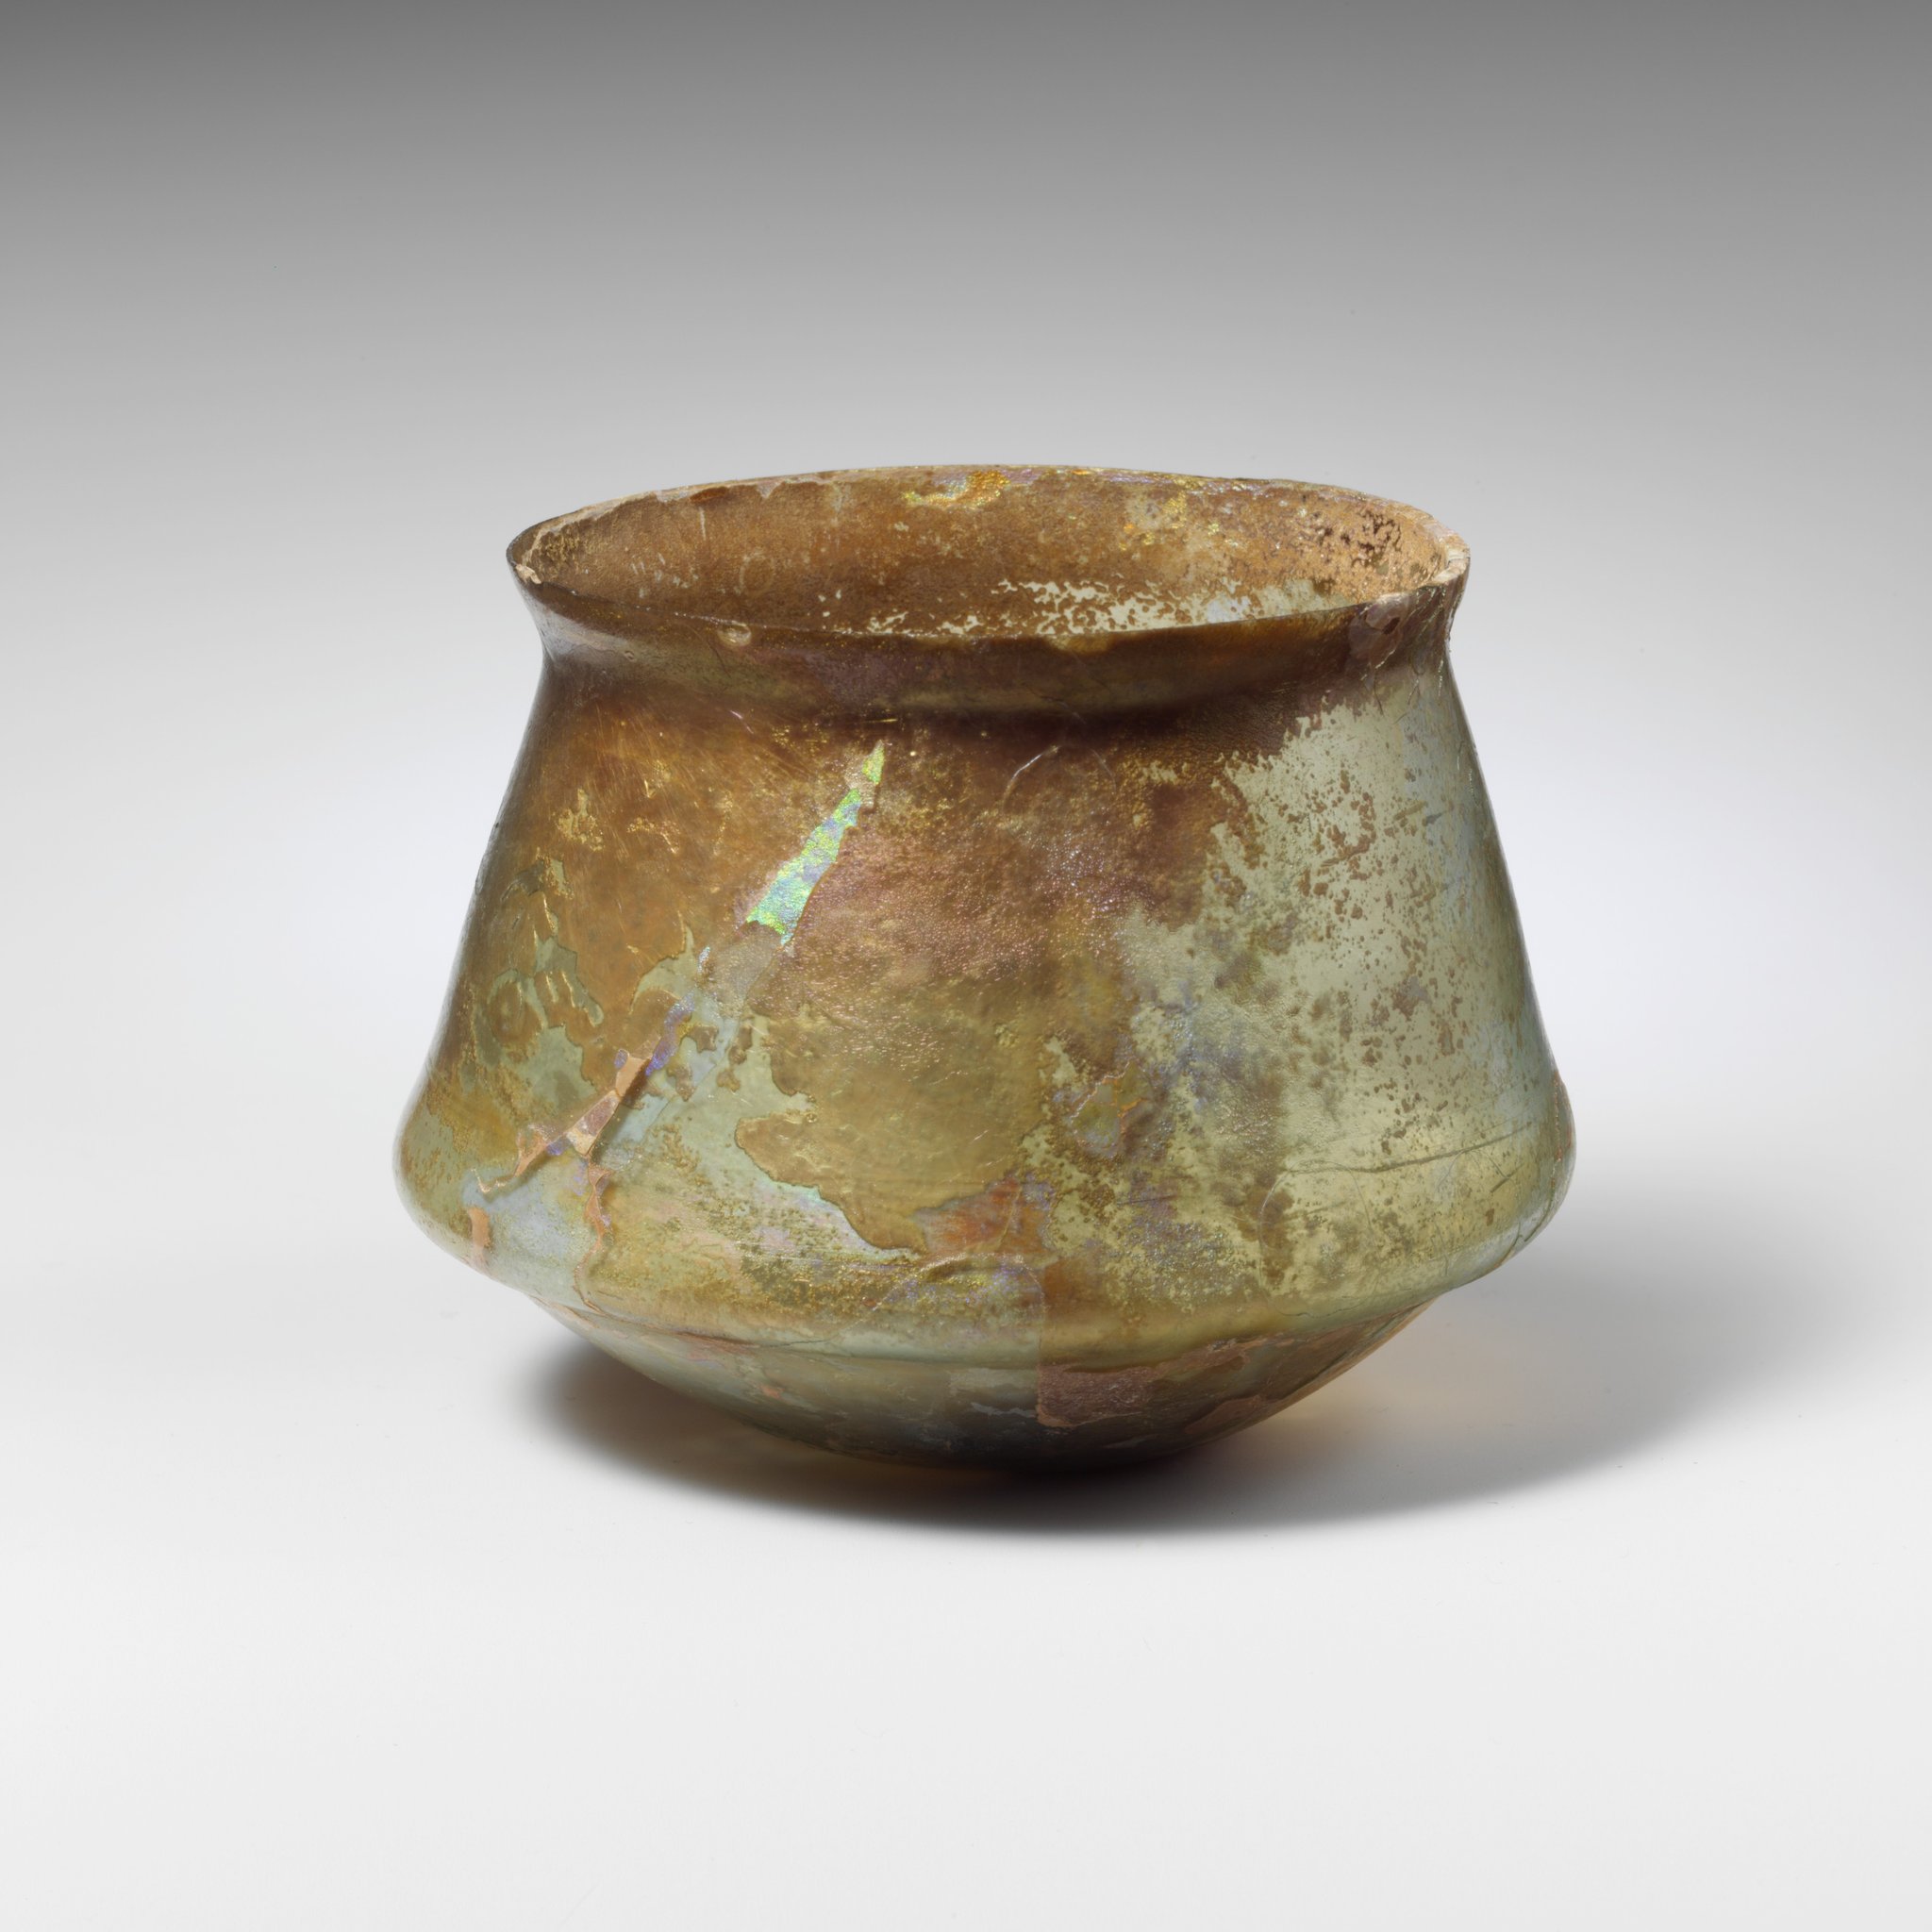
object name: cup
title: Glass cup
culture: roman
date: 201-300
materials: glass